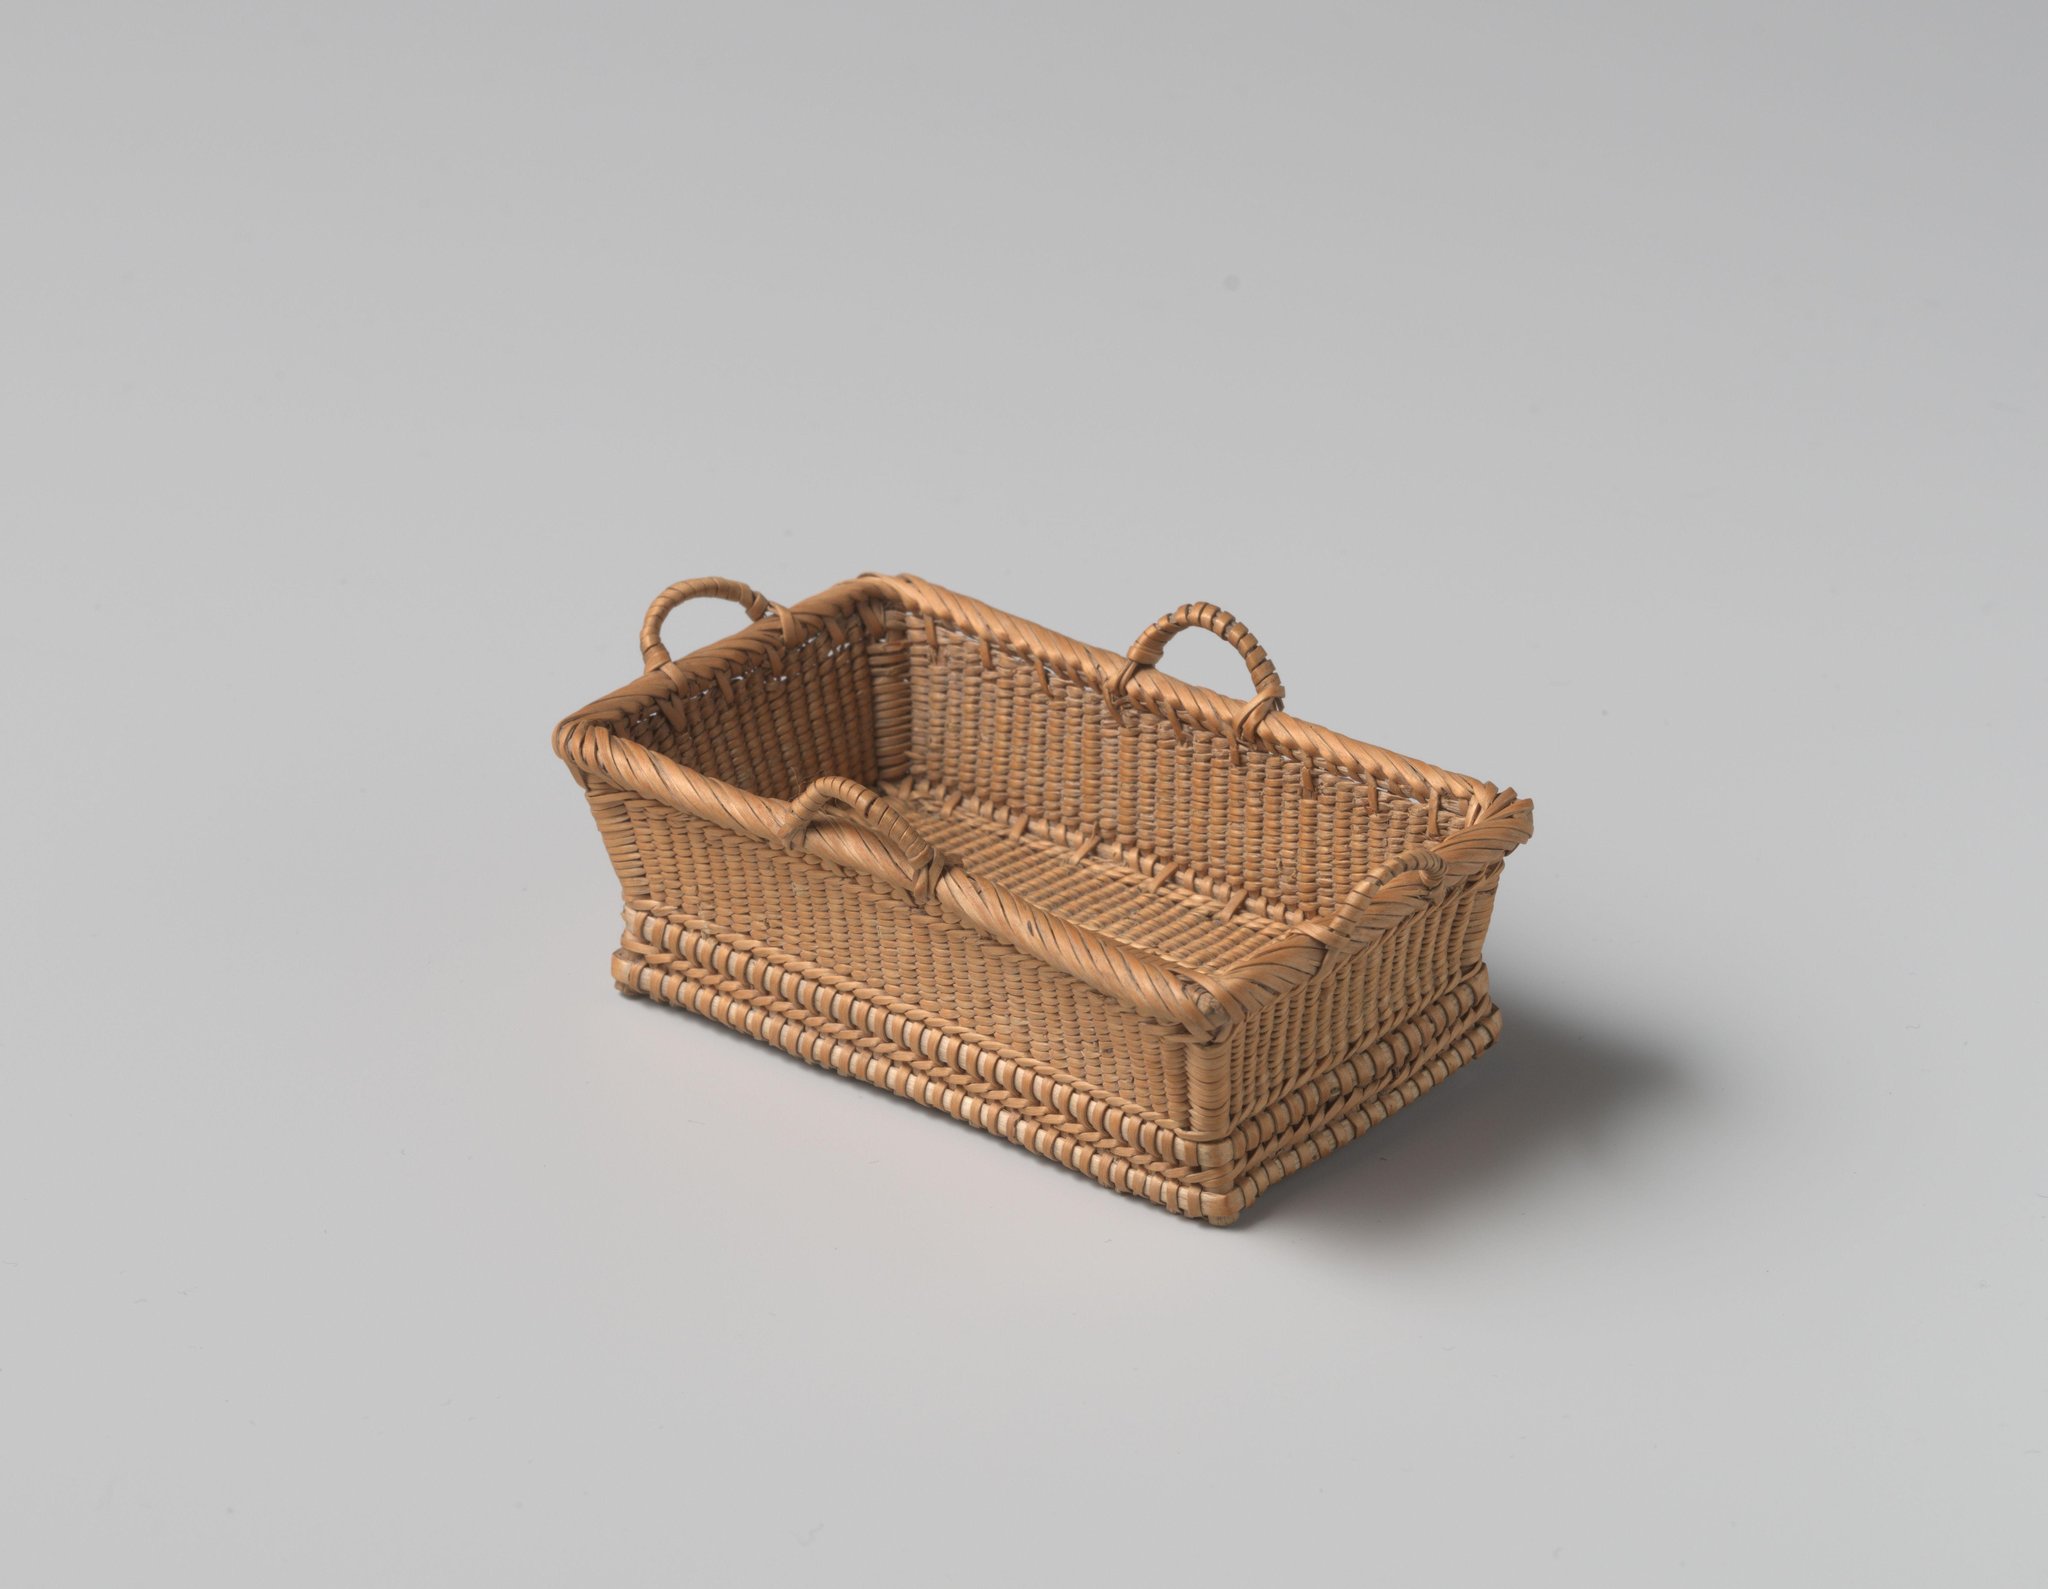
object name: kleermand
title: Baliemand van gespleten wilgenteen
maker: Anonymous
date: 1690-1710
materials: plant material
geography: halle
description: Rechthoekige baliemand (kleermand) van gespleten wilgenteen, fijnscheenwerk. Bovenop de vier wanden zitten handgrepen.